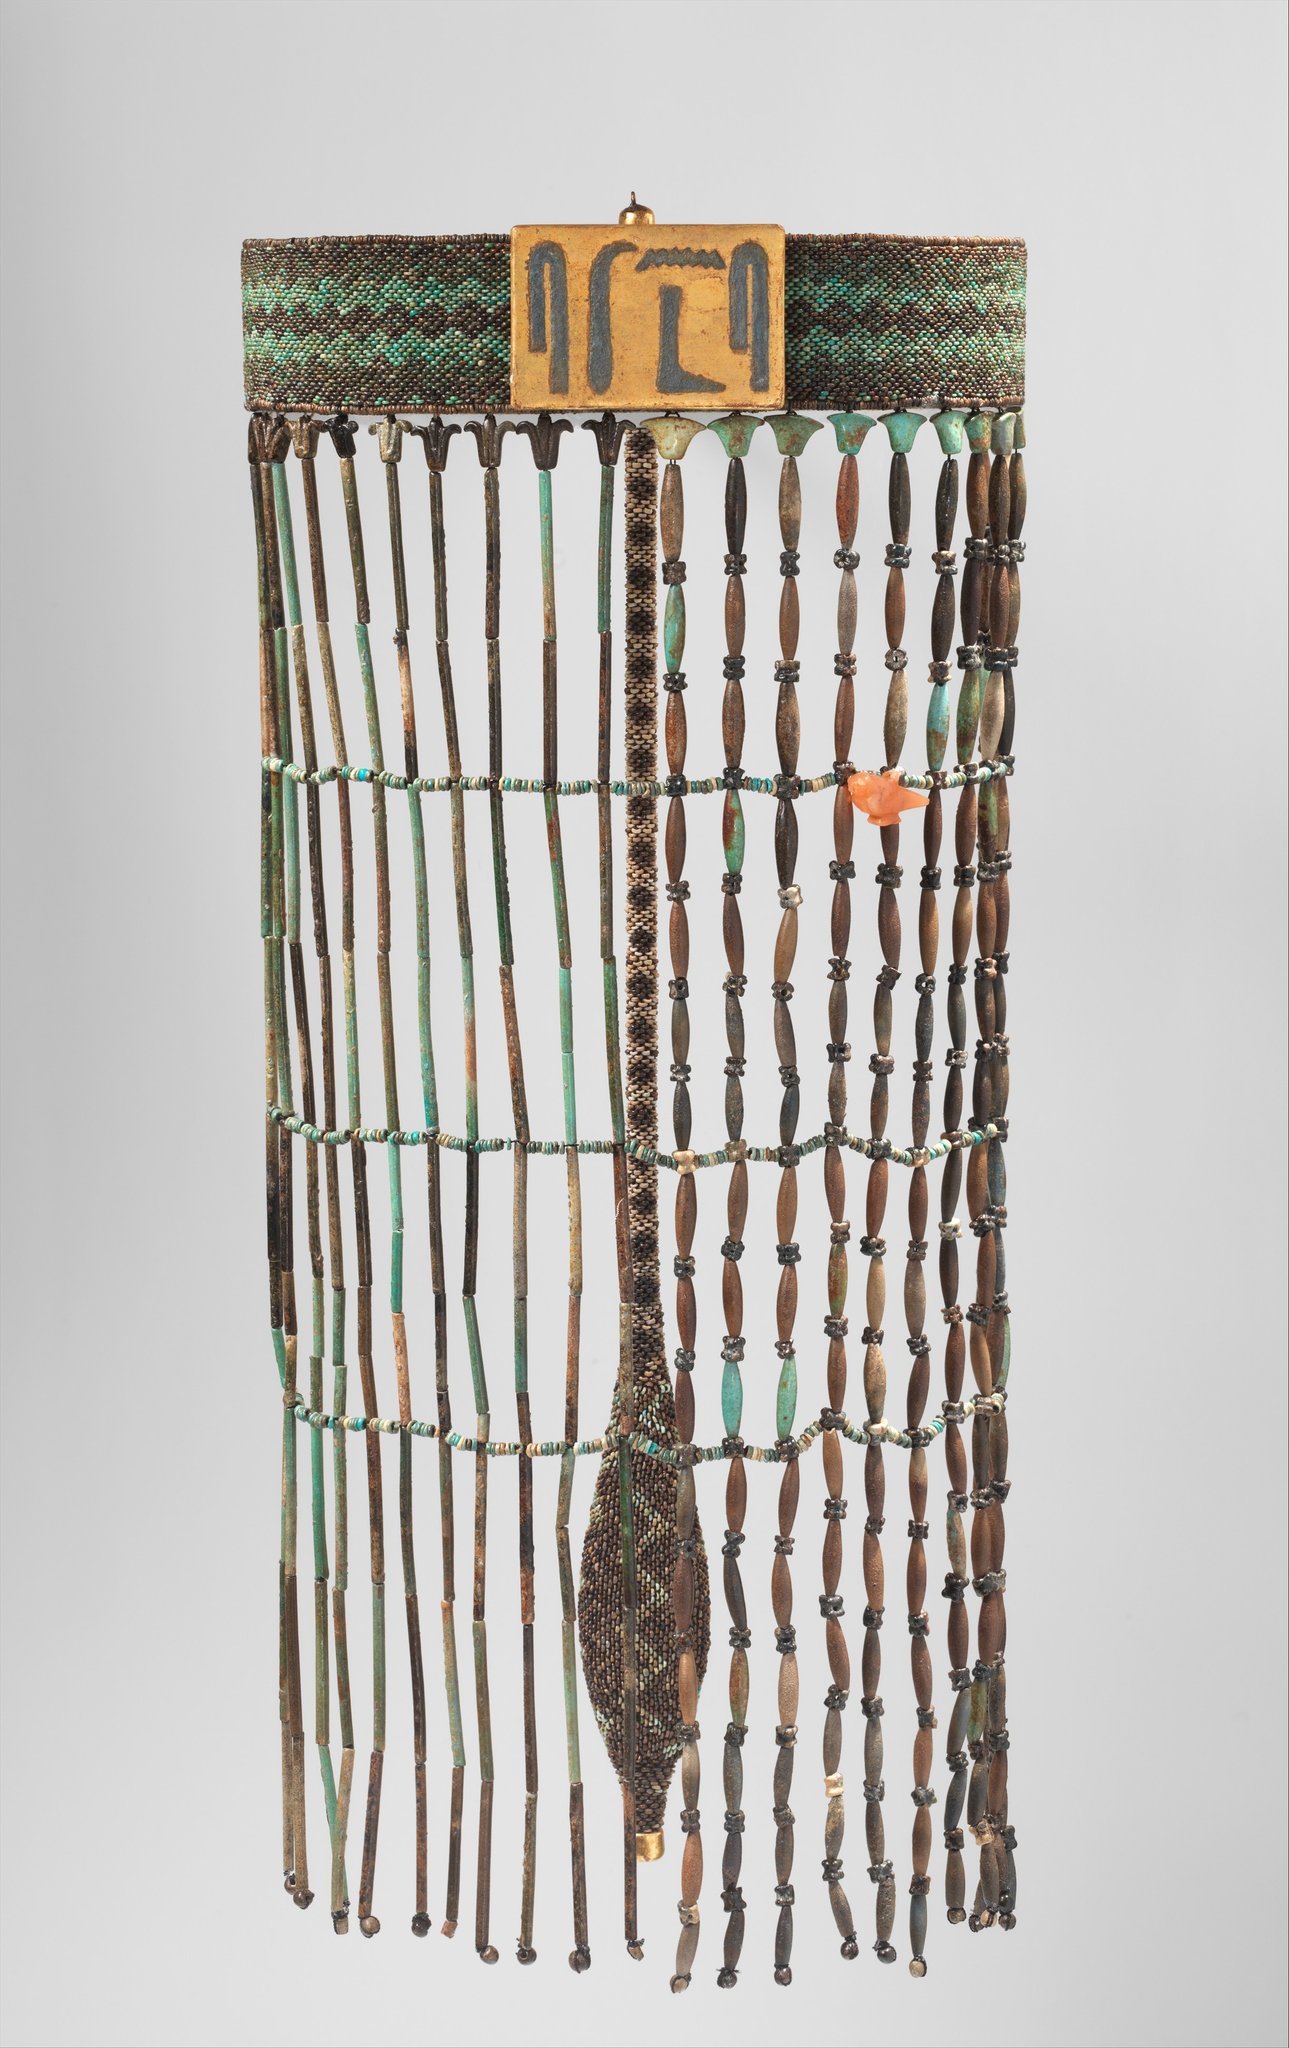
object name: apron, beadwork, senebtisi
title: Garment of Senebtisi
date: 1850-1775 BCE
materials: faience, paint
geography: egypt